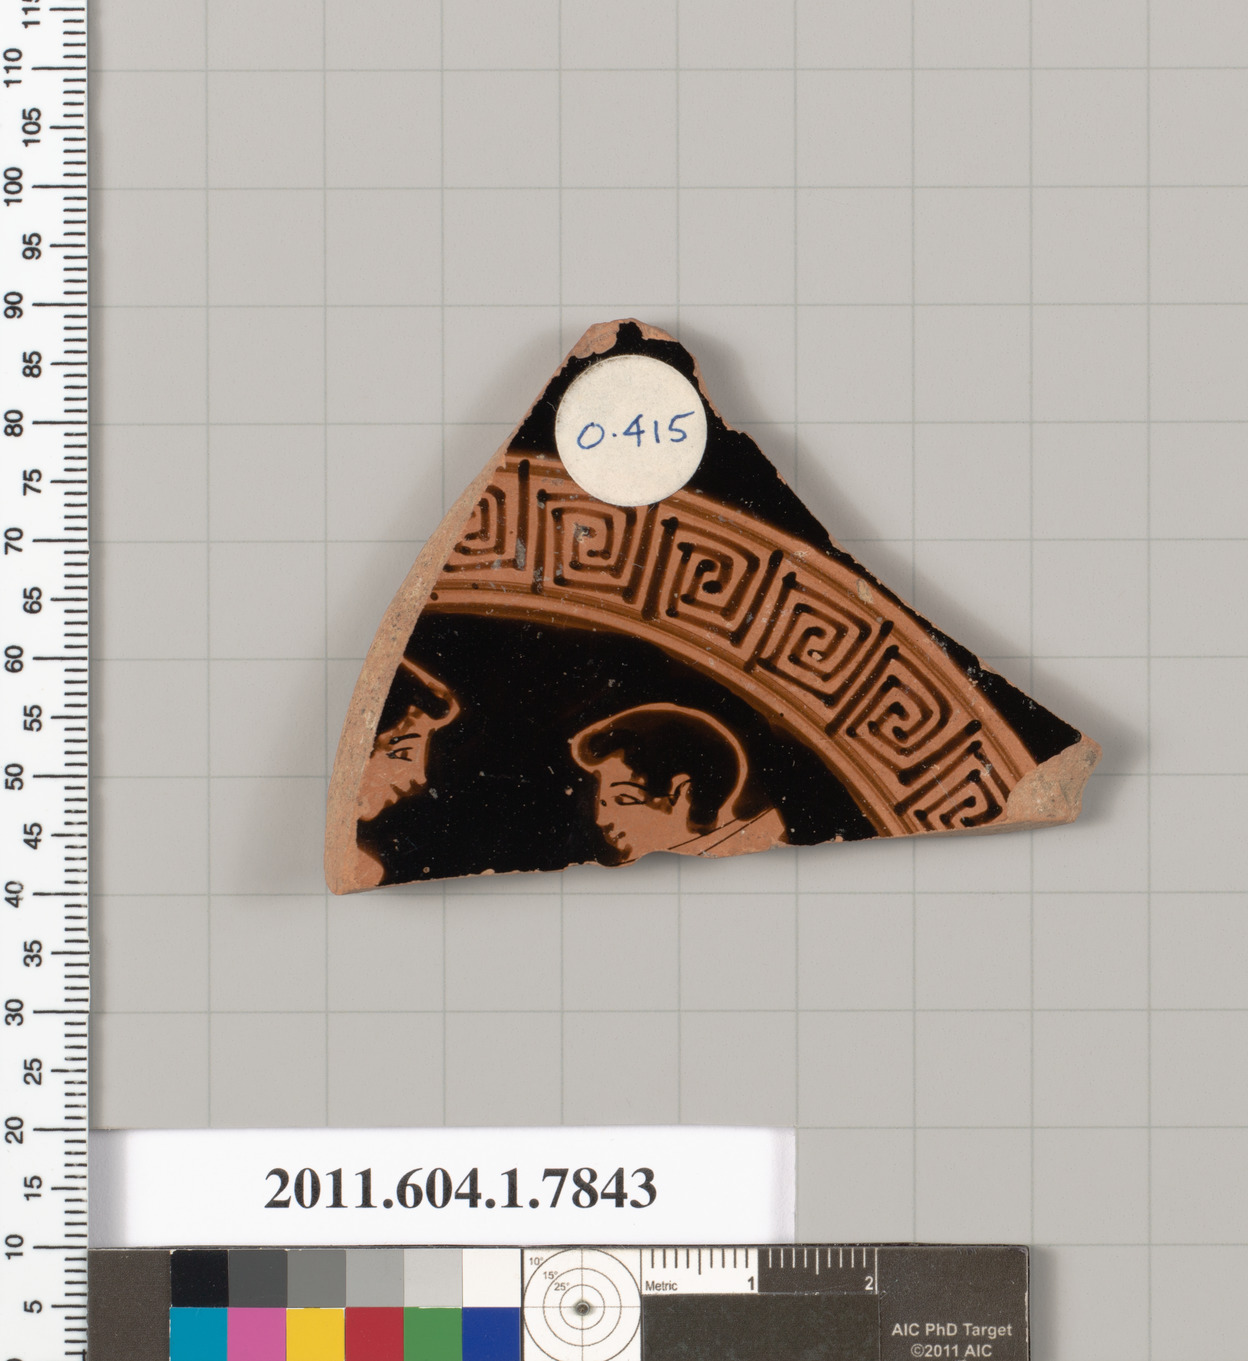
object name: kylix fragment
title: Terracotta fragment of a kylix (drinking cup)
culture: greek, attic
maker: painter of bologna 417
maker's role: artist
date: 460-450 BCE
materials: terracotta